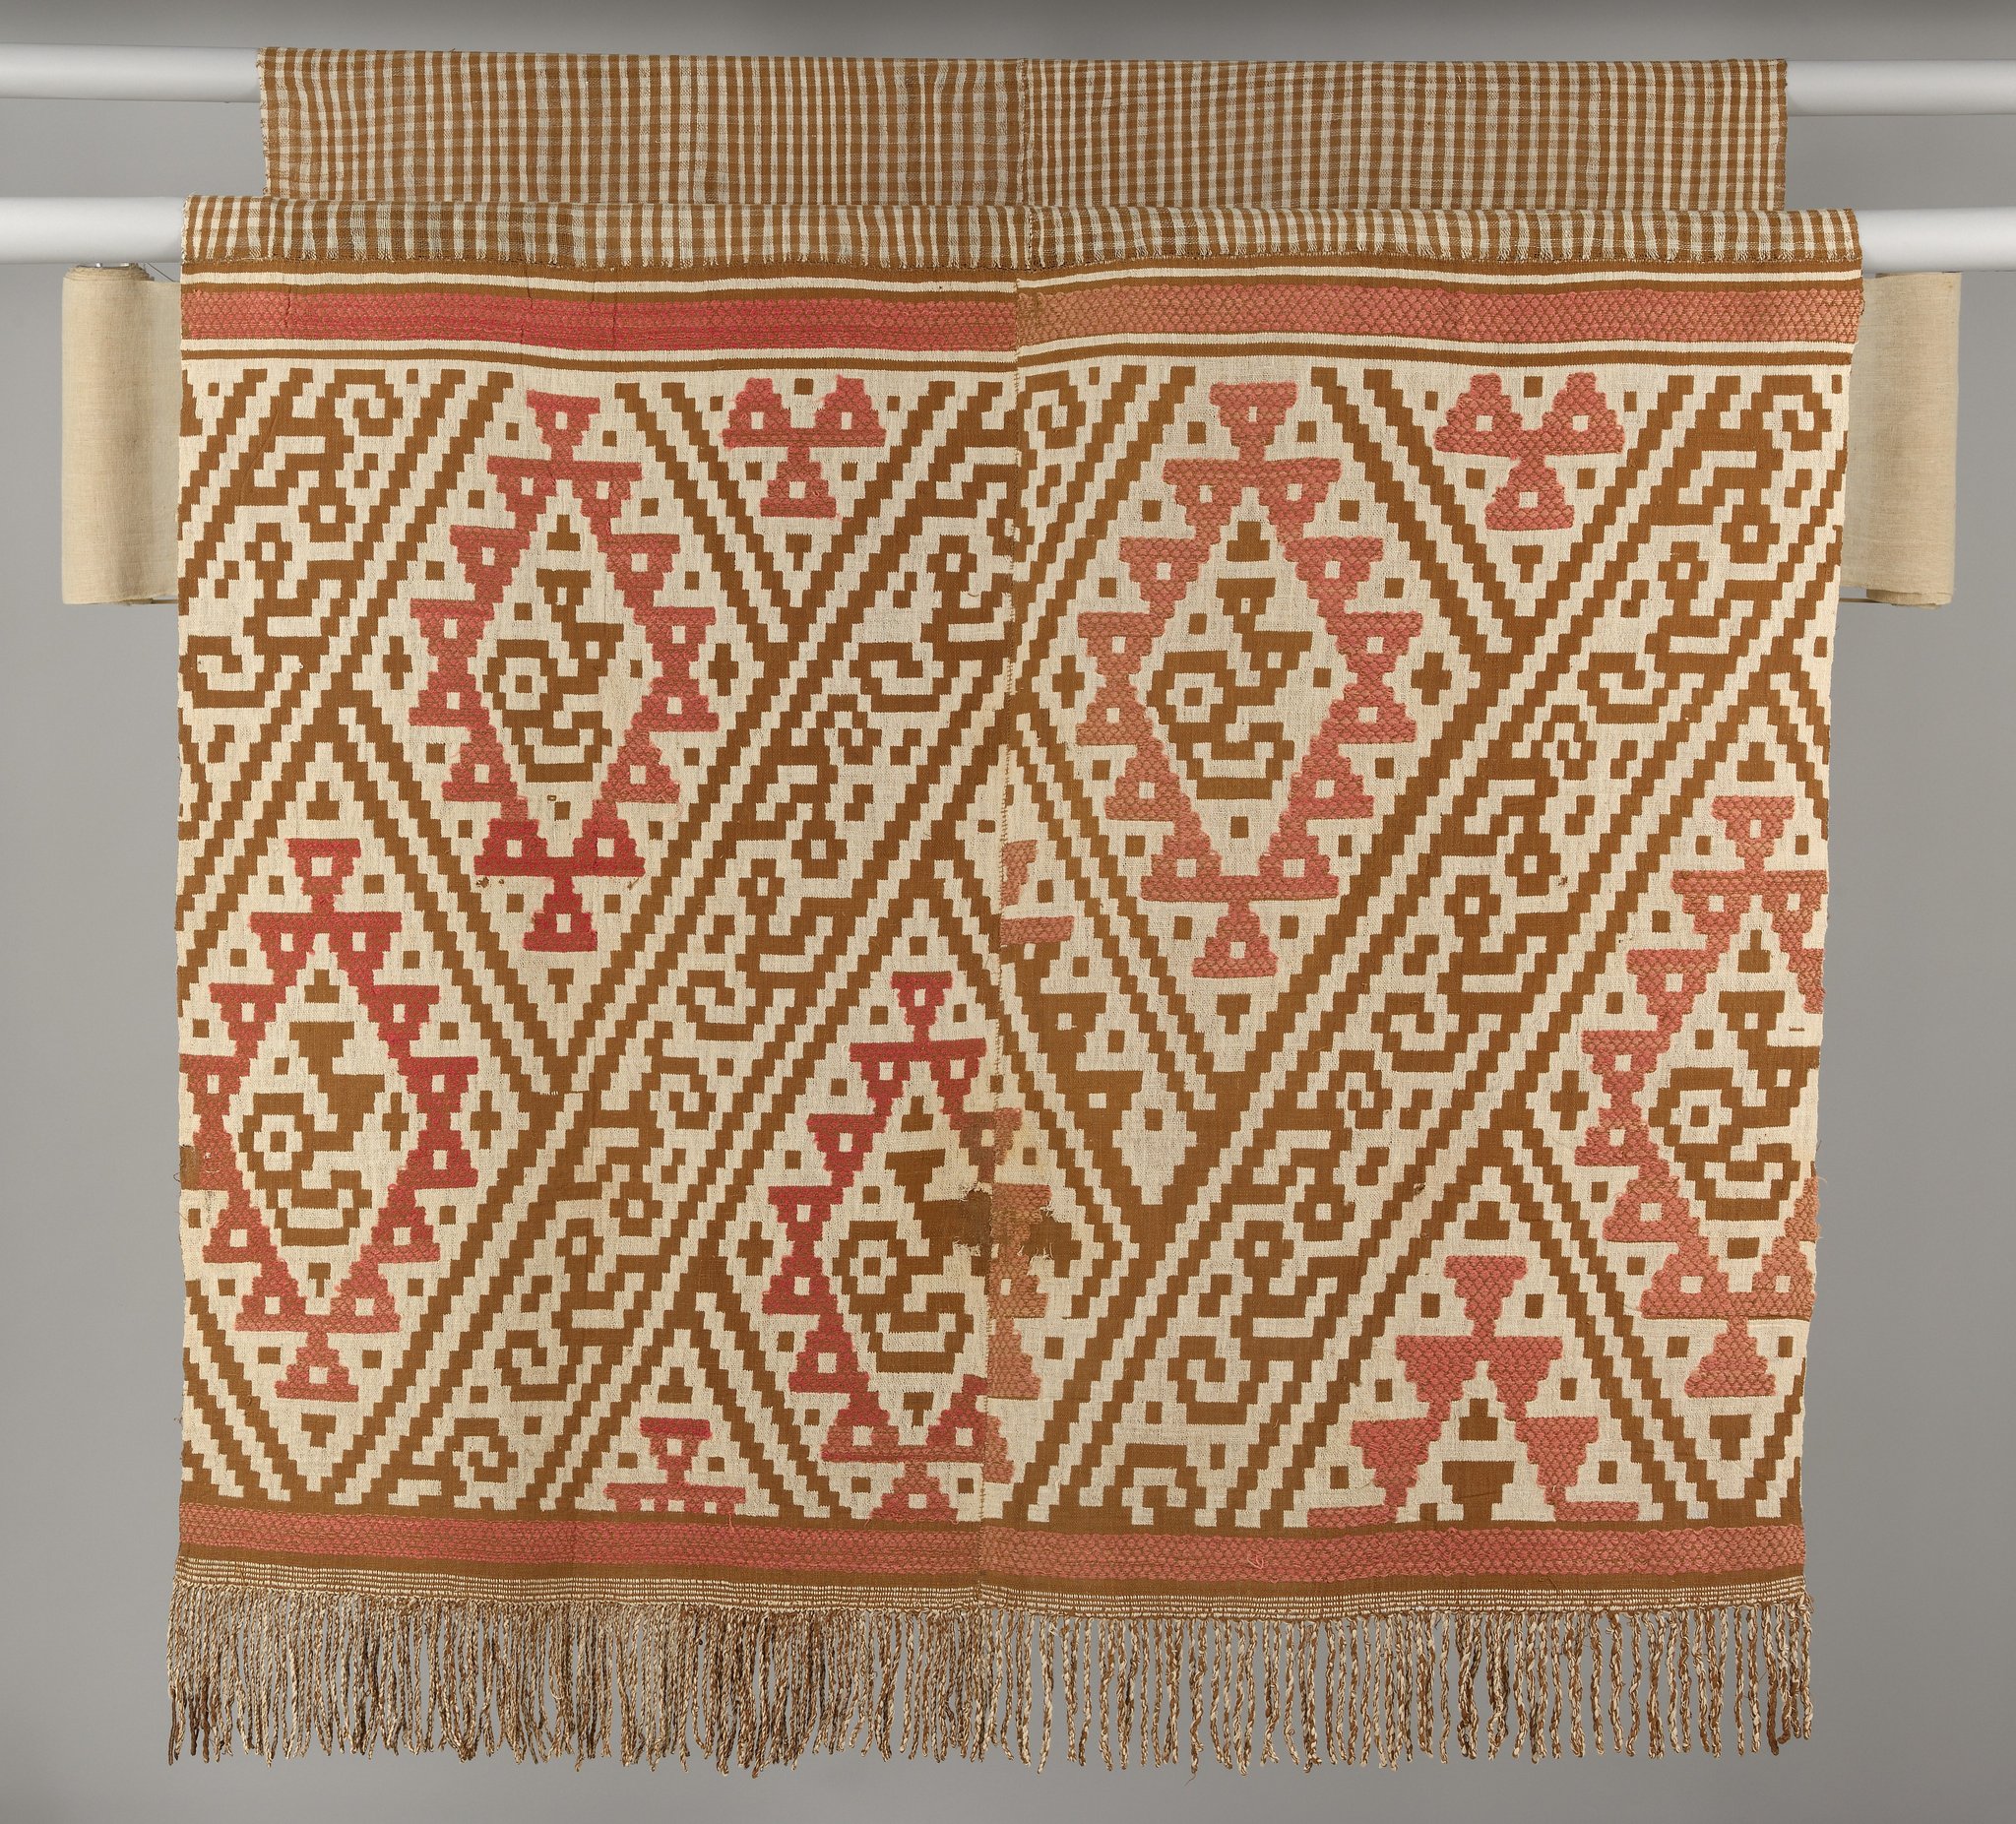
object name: loincloth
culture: chimú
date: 1101-1500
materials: animal fiber, cotton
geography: peru